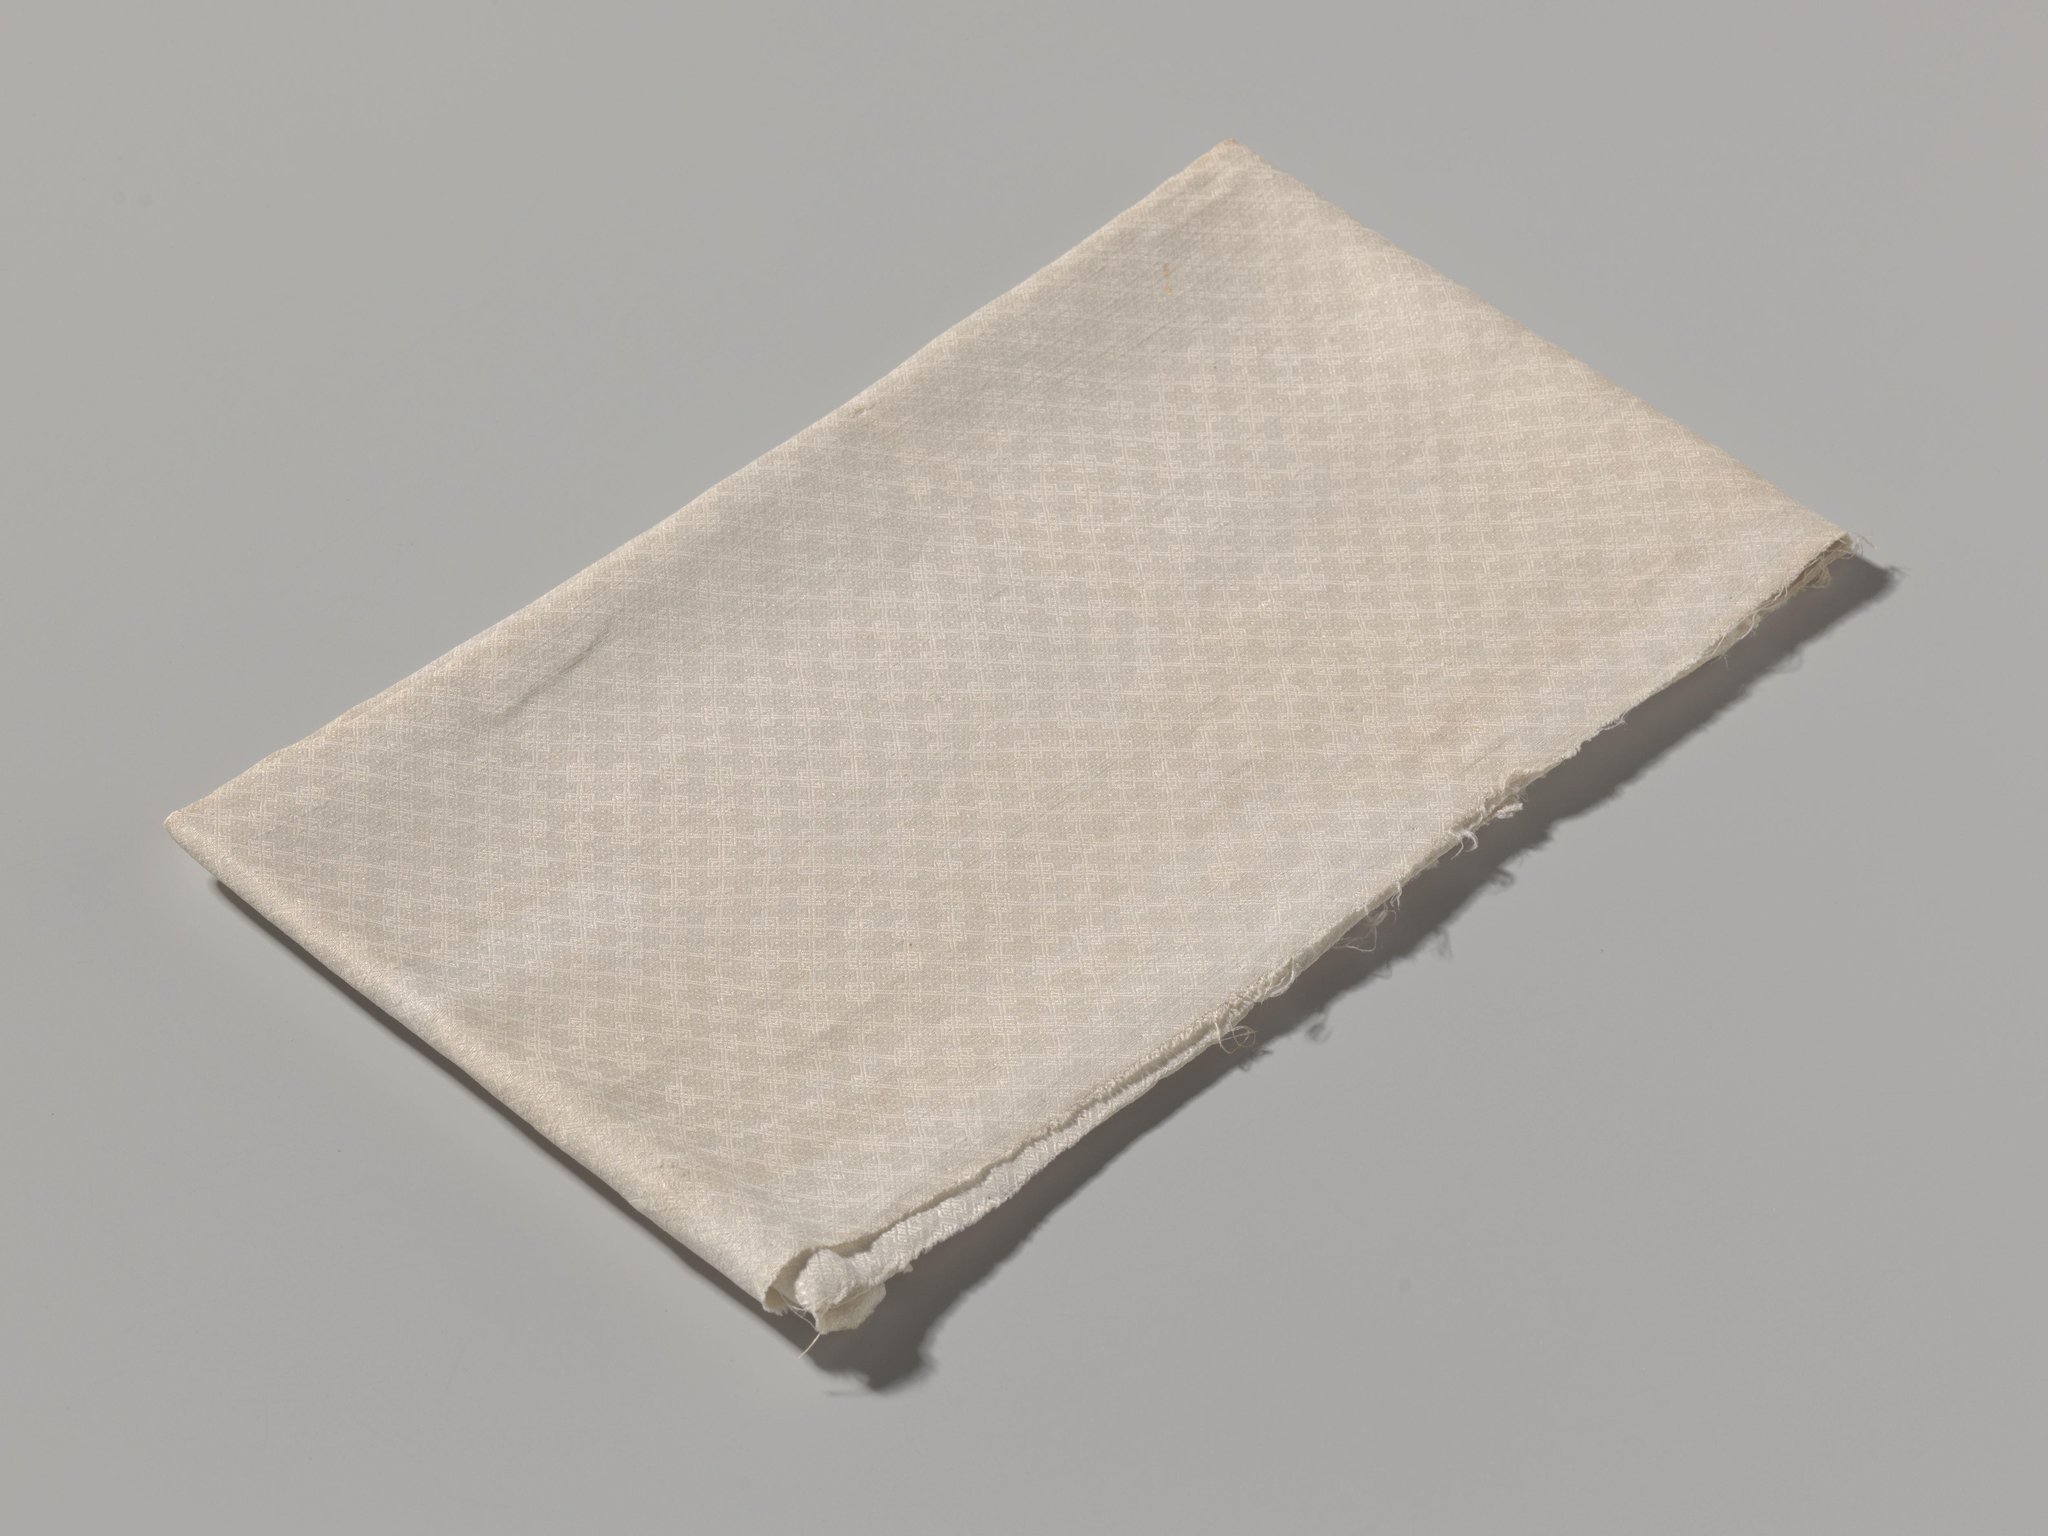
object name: napkin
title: Fragment van een linnen servet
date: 1600-1699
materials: linen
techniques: weave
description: Verknipt servet van linnen, met een "kruiswerk" patroon. Bij het fragment hoort een tweede fragment van een verknipt servet met invnr. BK-16697-A. Het weefsel is een combinatie van linnen- en keperbinding.